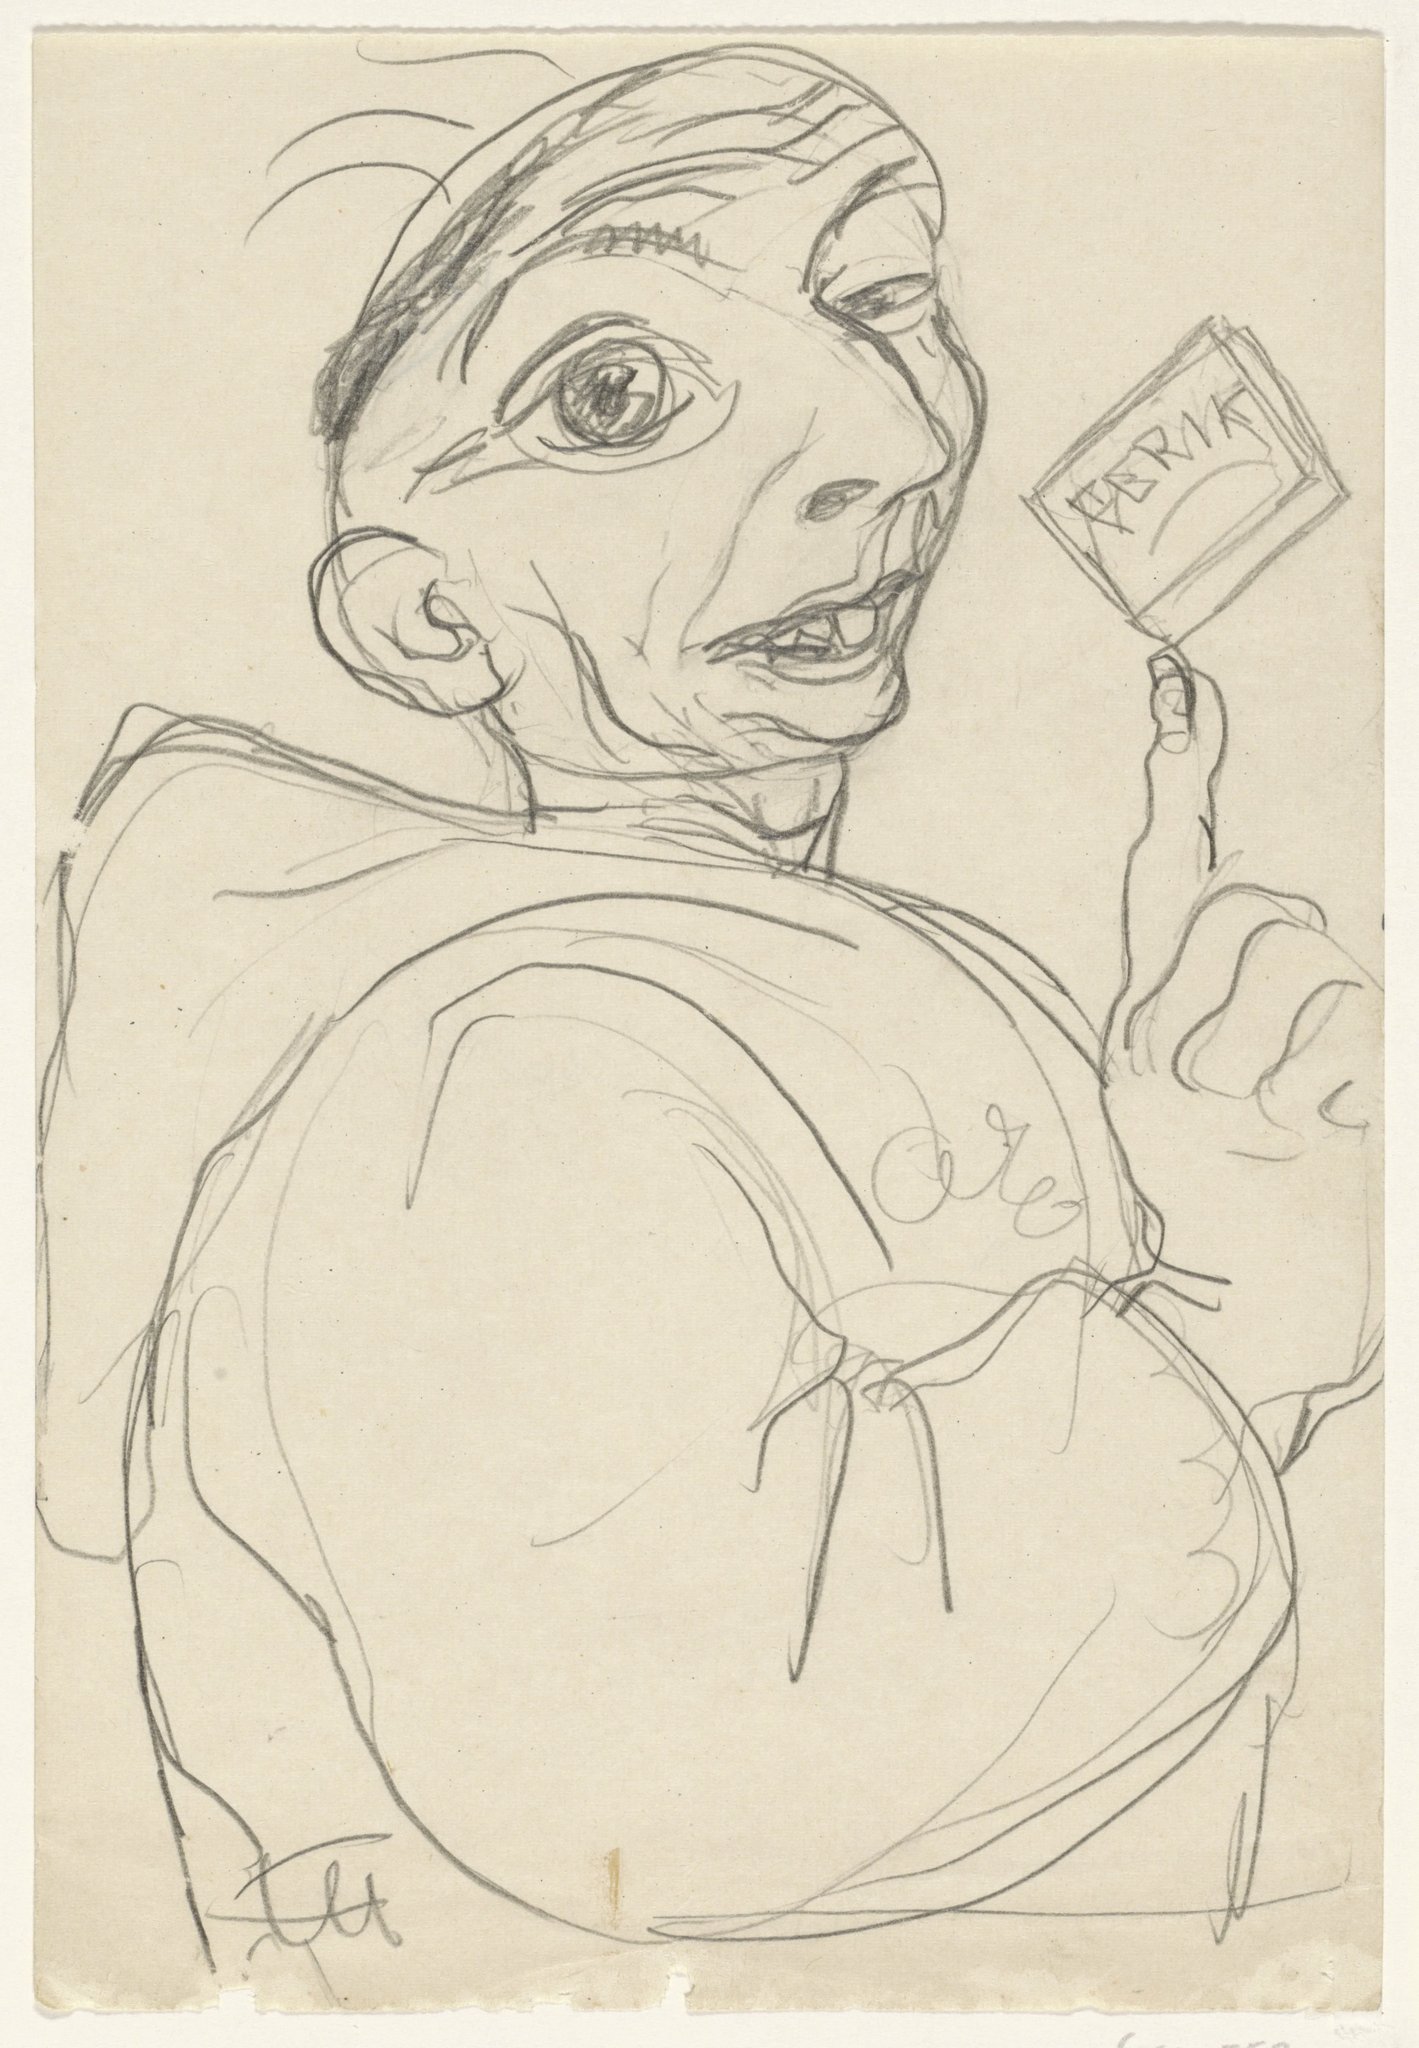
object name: drawing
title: Karikatuur van Leo Gestel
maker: leo gestel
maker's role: draughtsman, print maker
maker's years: 1881-1941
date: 1911-1941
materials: paper, pencil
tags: draughtsman, leo gestel, sick-bed, historical persons, portrait, self-portrait of artist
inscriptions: collector's mark: Lugt 2228